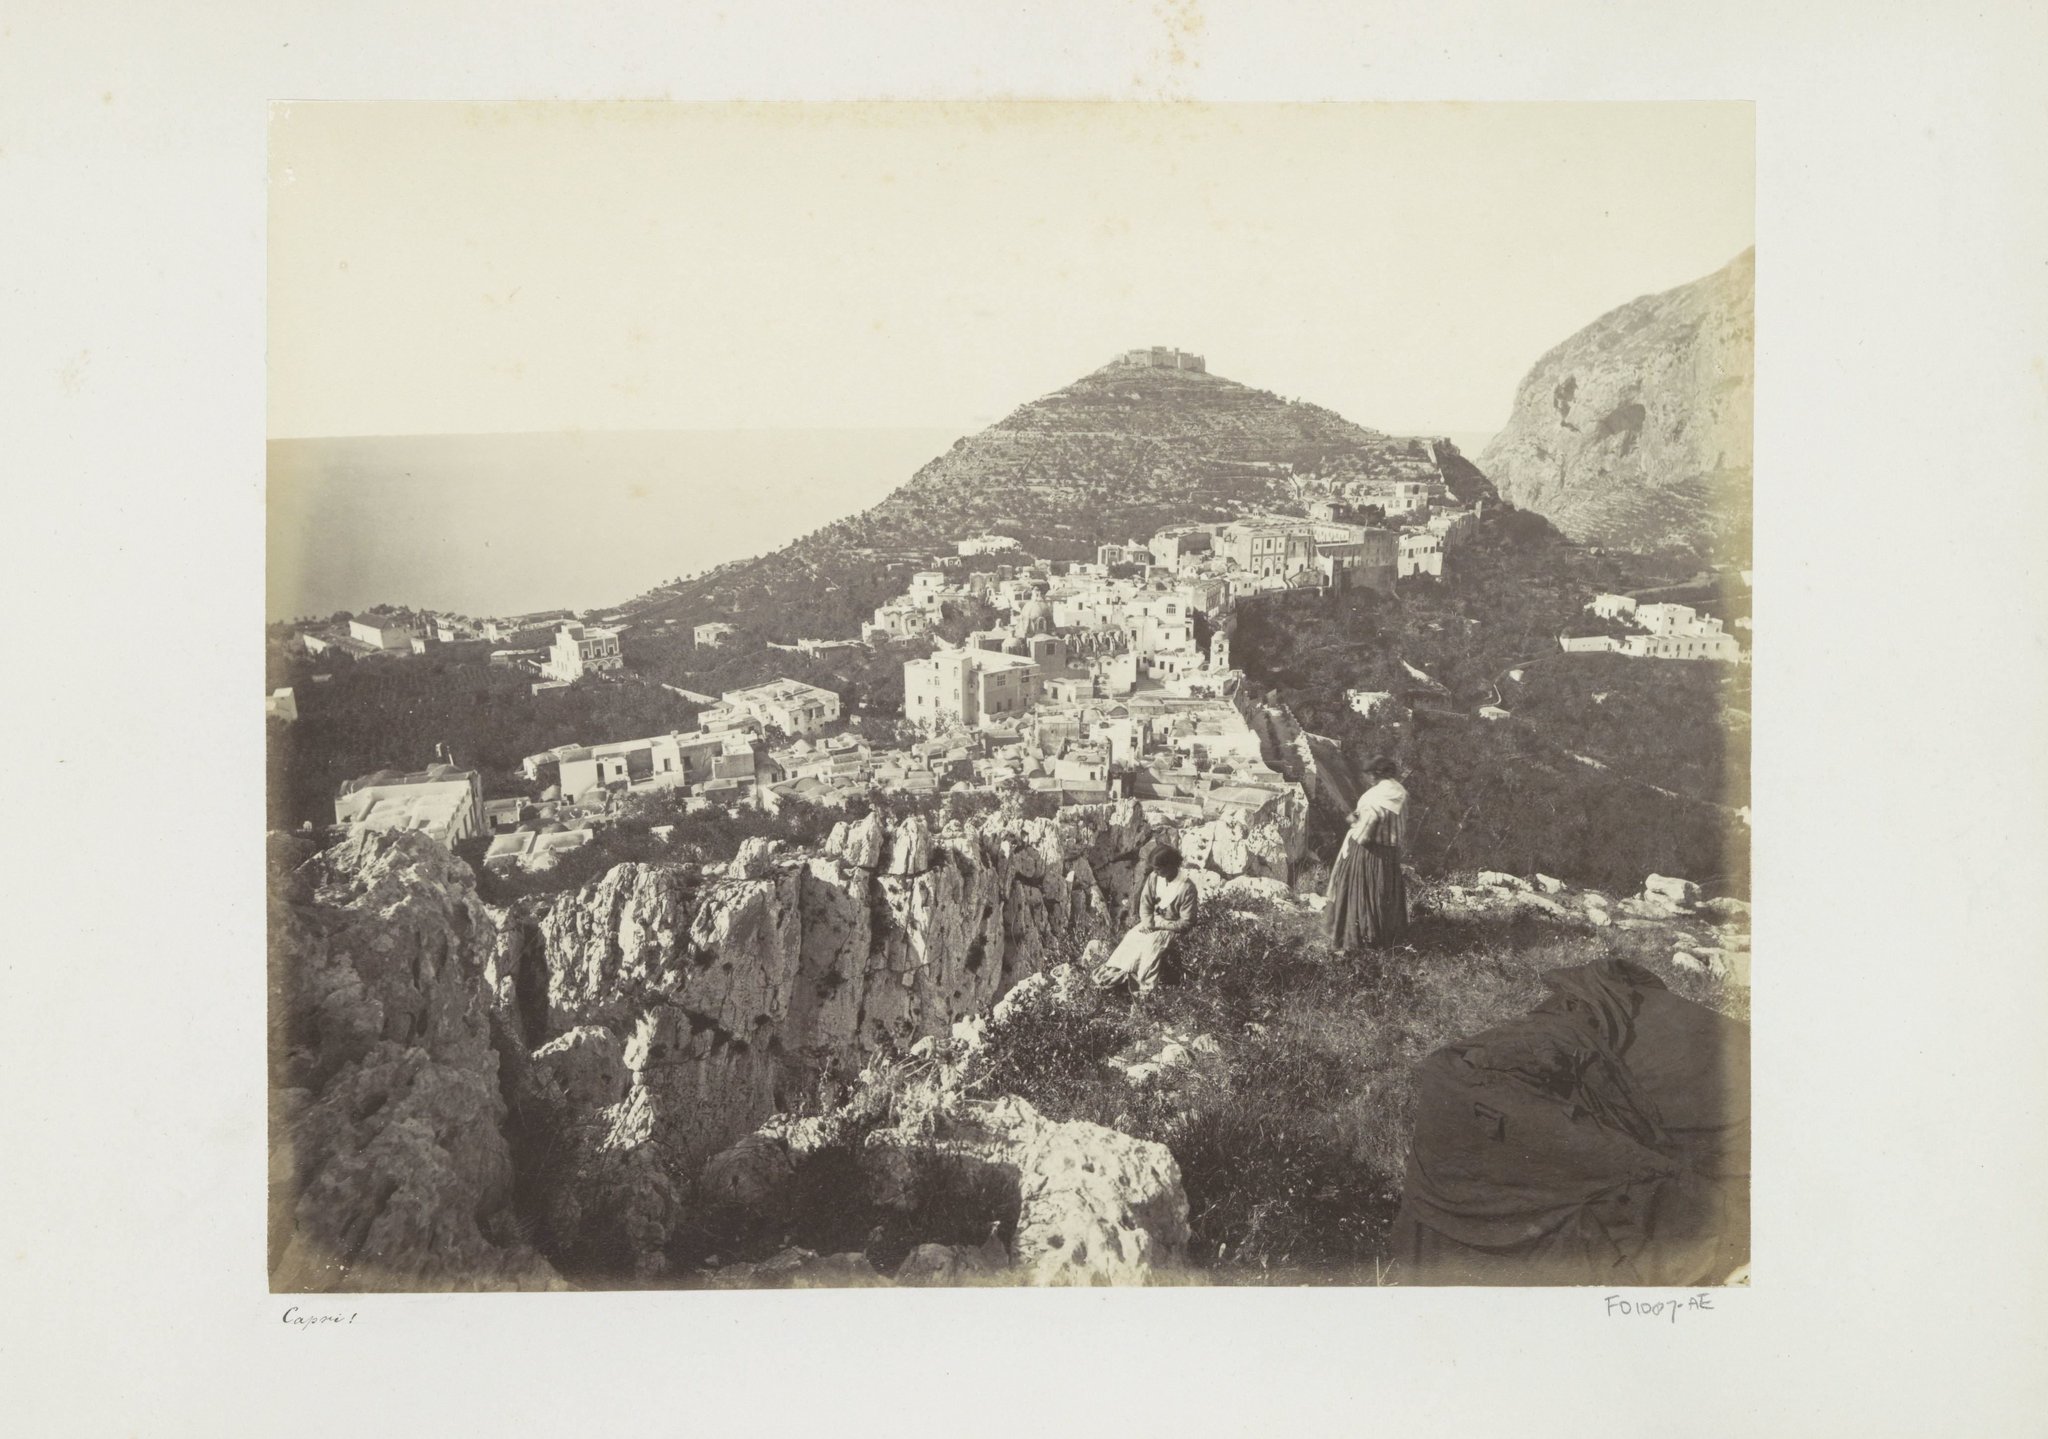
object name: photograph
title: Capri!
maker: Anonymous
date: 1865-1875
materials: paper, photographic support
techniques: albumen print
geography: capri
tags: prospect of village, silhouette of village, capri, isola di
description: Onderdeel van Reisalbum met foto's van bezienswaardigheden in Napels en omgeving.